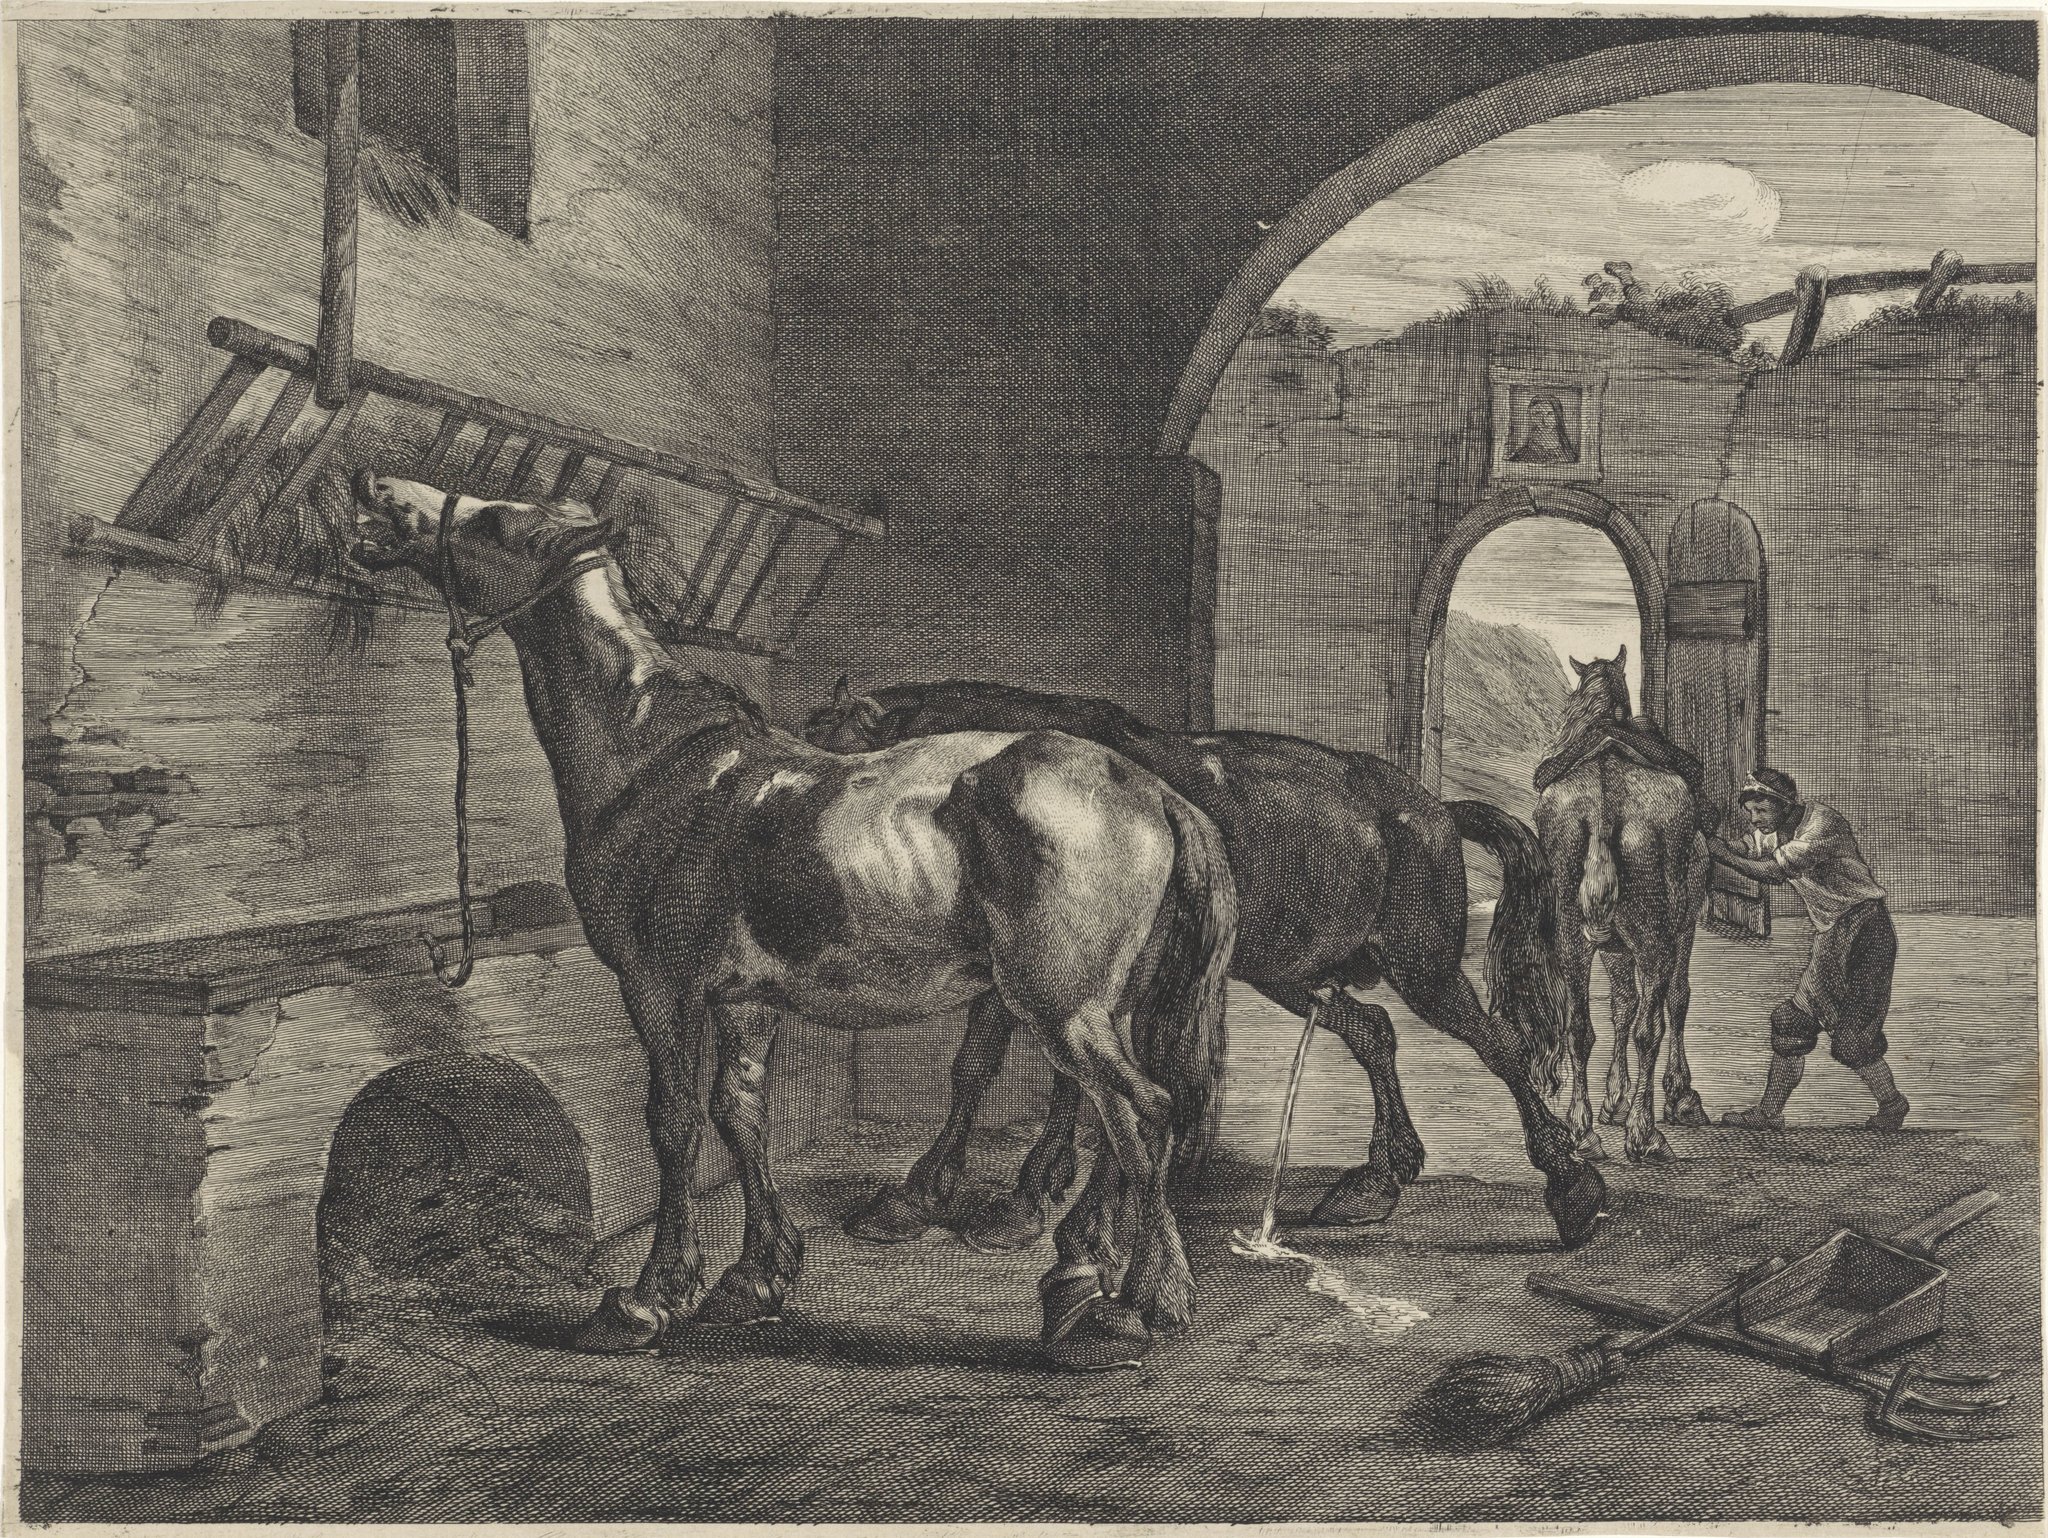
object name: print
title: Paardenstal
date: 1638-1658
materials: paper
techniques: engraving, etching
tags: barn, agricultural products and by-products: hay, saddle, horse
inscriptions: collector's mark: Lugt 240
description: In een stal eet een aangelijnd paard hooi uit een ruif, het paard ernaast unirneert overvloedig. Op de binnenplaats, op de achtergrond, zadelt een jongen een derde paard. Boven de deur naar de binnenplaats hangt een beeltenis.